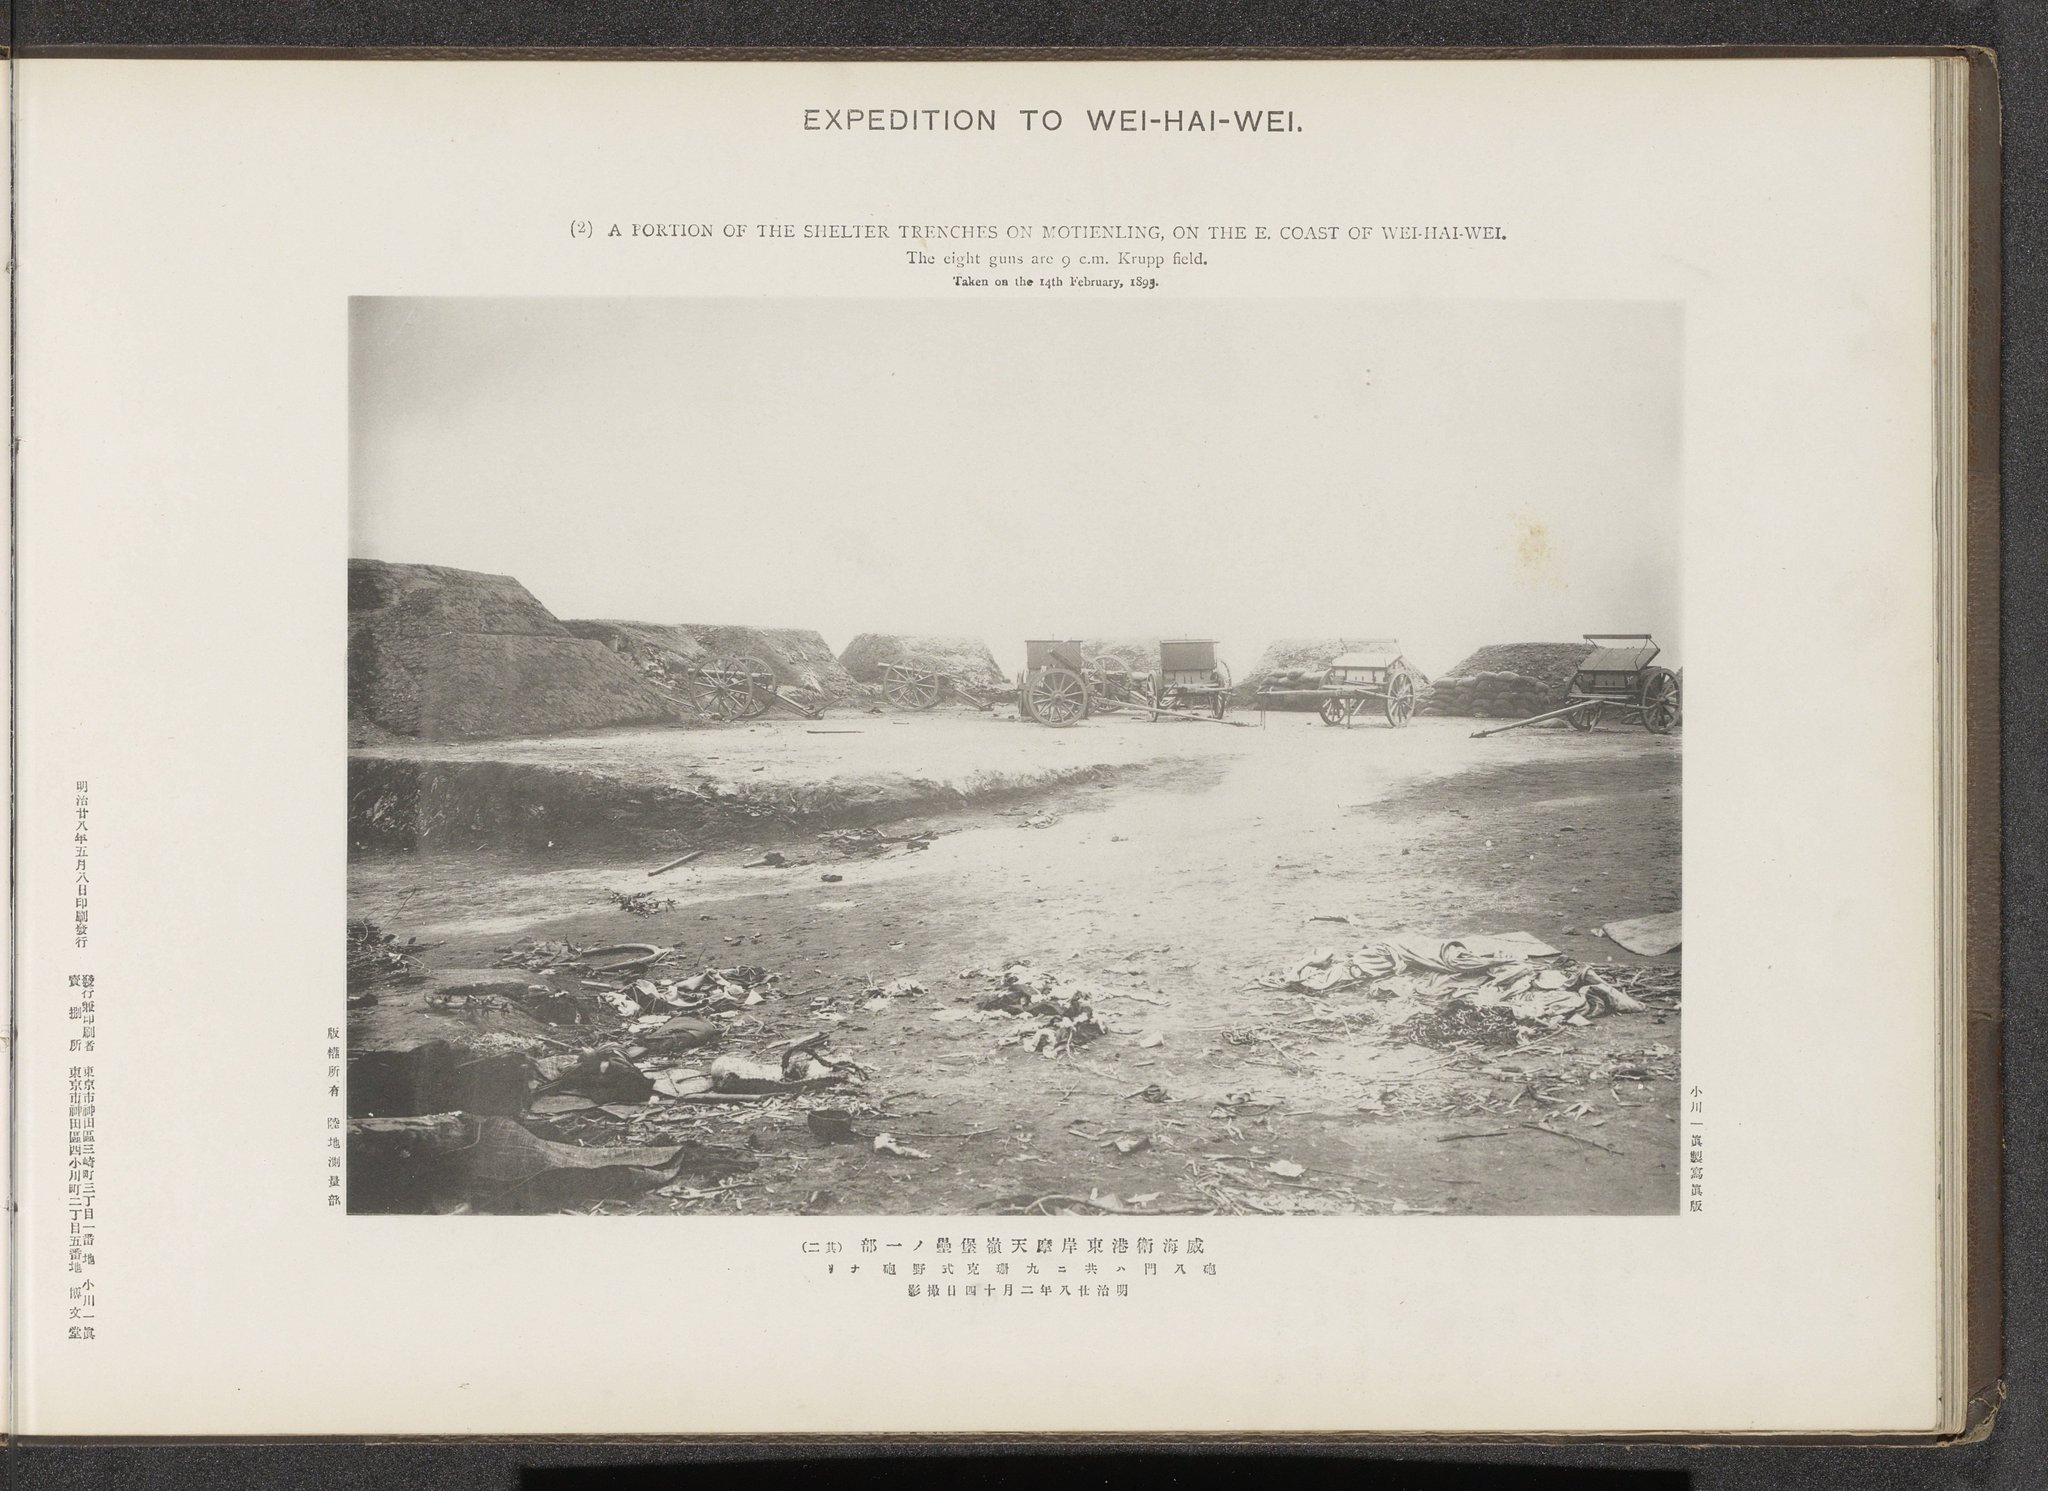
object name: photomechanical print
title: A portion of the shelter trenches on Motienling, on the E. coast of Wei-Hai-Wei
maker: kazumasa ogawa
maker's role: auteur, fotograaf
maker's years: 1860-1929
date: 1895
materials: paper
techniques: photograph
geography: japan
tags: firearms: cannon, trenches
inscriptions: inscription: ‘The eight guns are 9 c.m. Krupp field.’, inscription: ‘Expedition to Wei-Hai-Wei.’